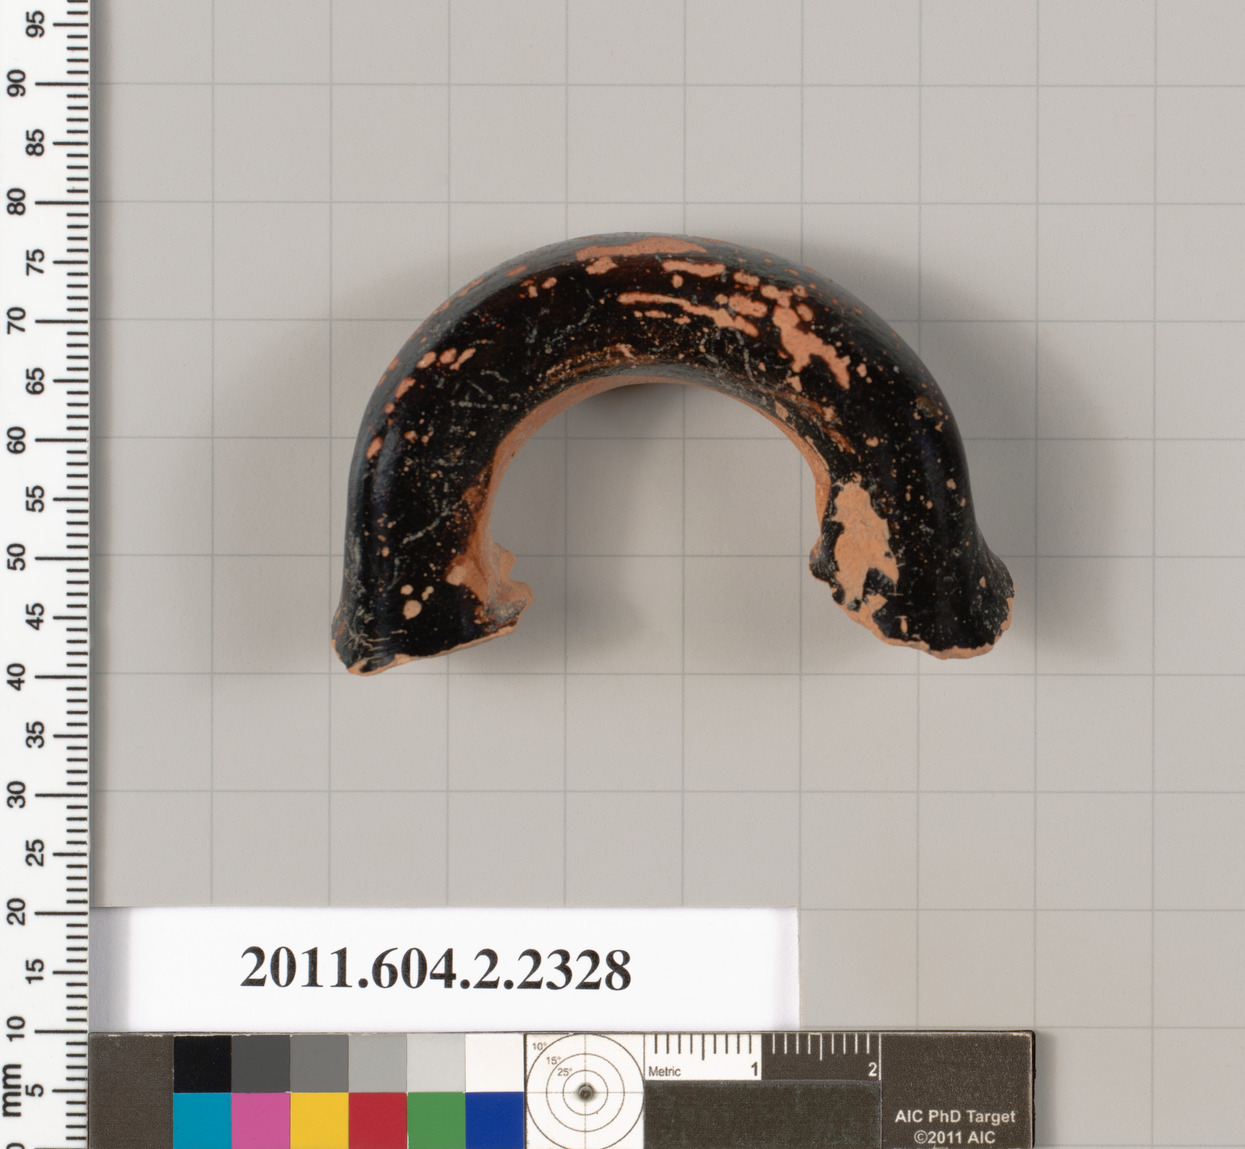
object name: skyphos fragment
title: Terracotta fragment of a skyphos (deep drinking cup)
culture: greek, attic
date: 600-401 BCE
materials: terracotta